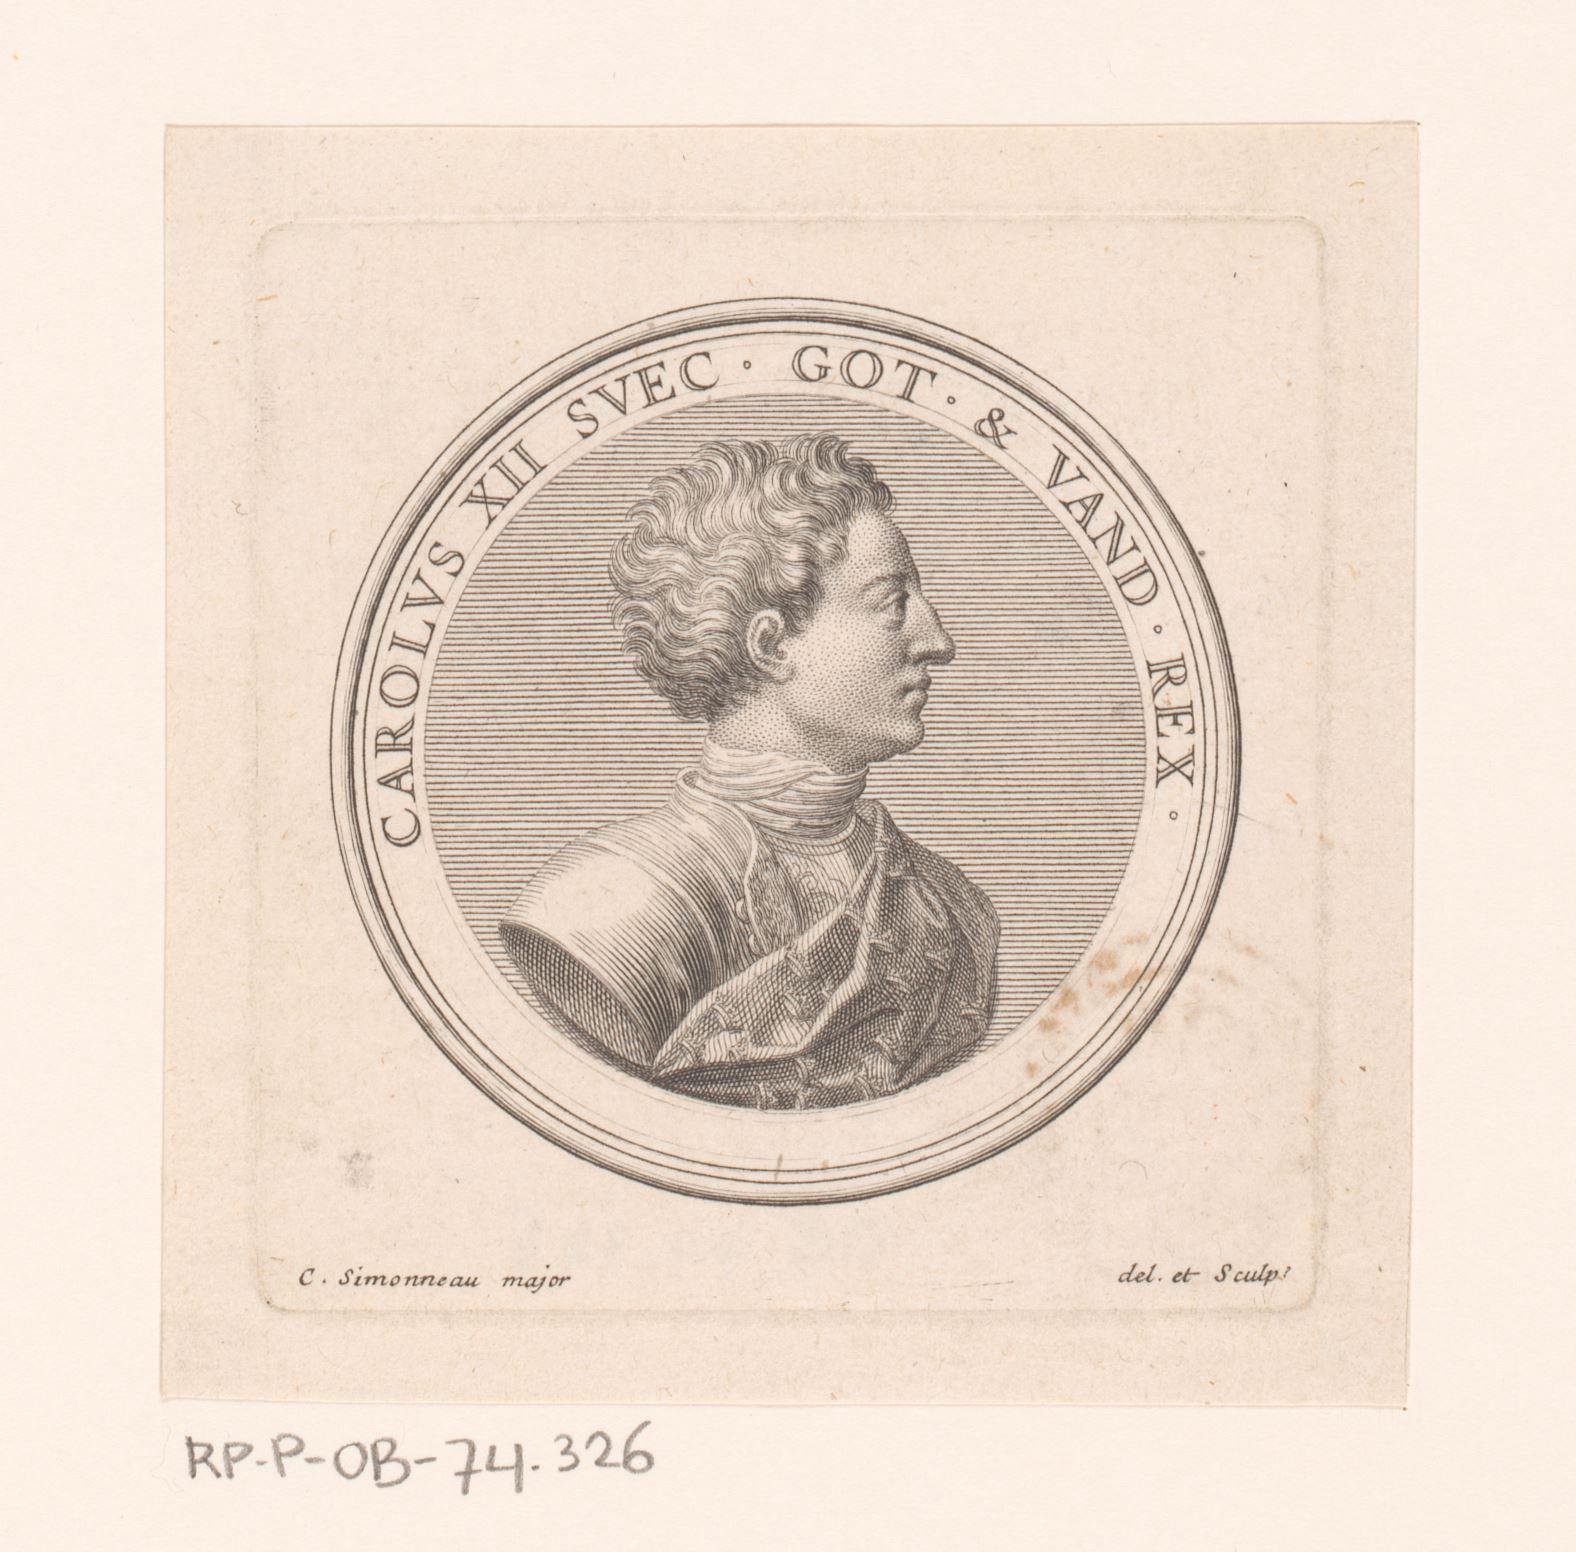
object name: print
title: Portret van koning Karel XII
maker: charles louis simonneau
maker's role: print maker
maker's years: 1645-1728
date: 1692-1728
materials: paper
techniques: engraving, etching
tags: historical persons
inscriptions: collector's mark: Lugt 240